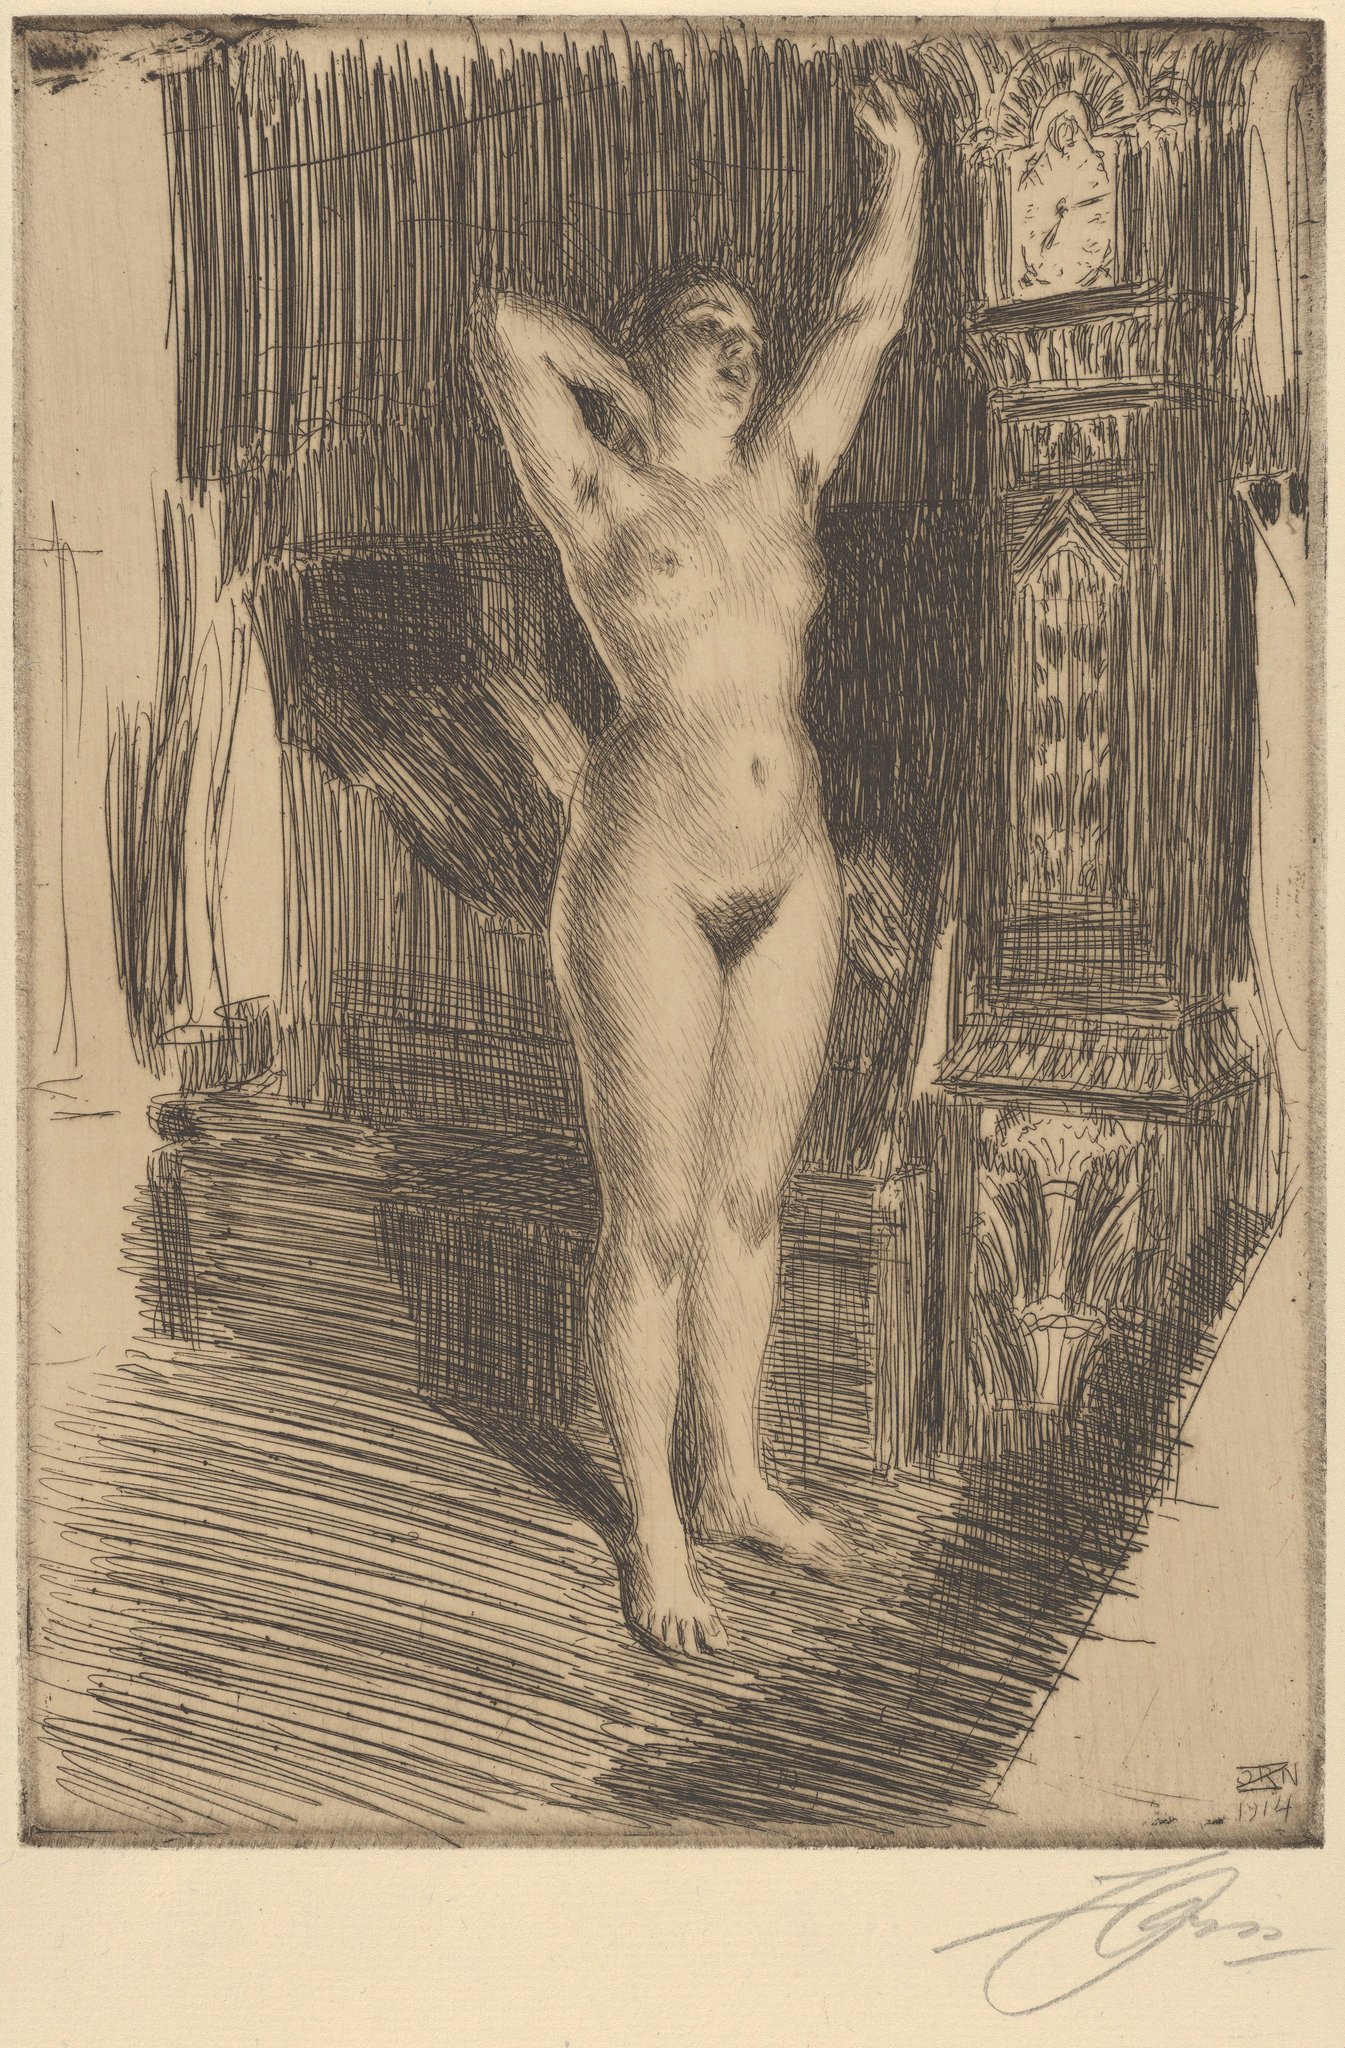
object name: print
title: Early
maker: anders zorn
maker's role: artist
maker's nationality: swedish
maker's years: 1860-1920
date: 1914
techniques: etching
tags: female nudes